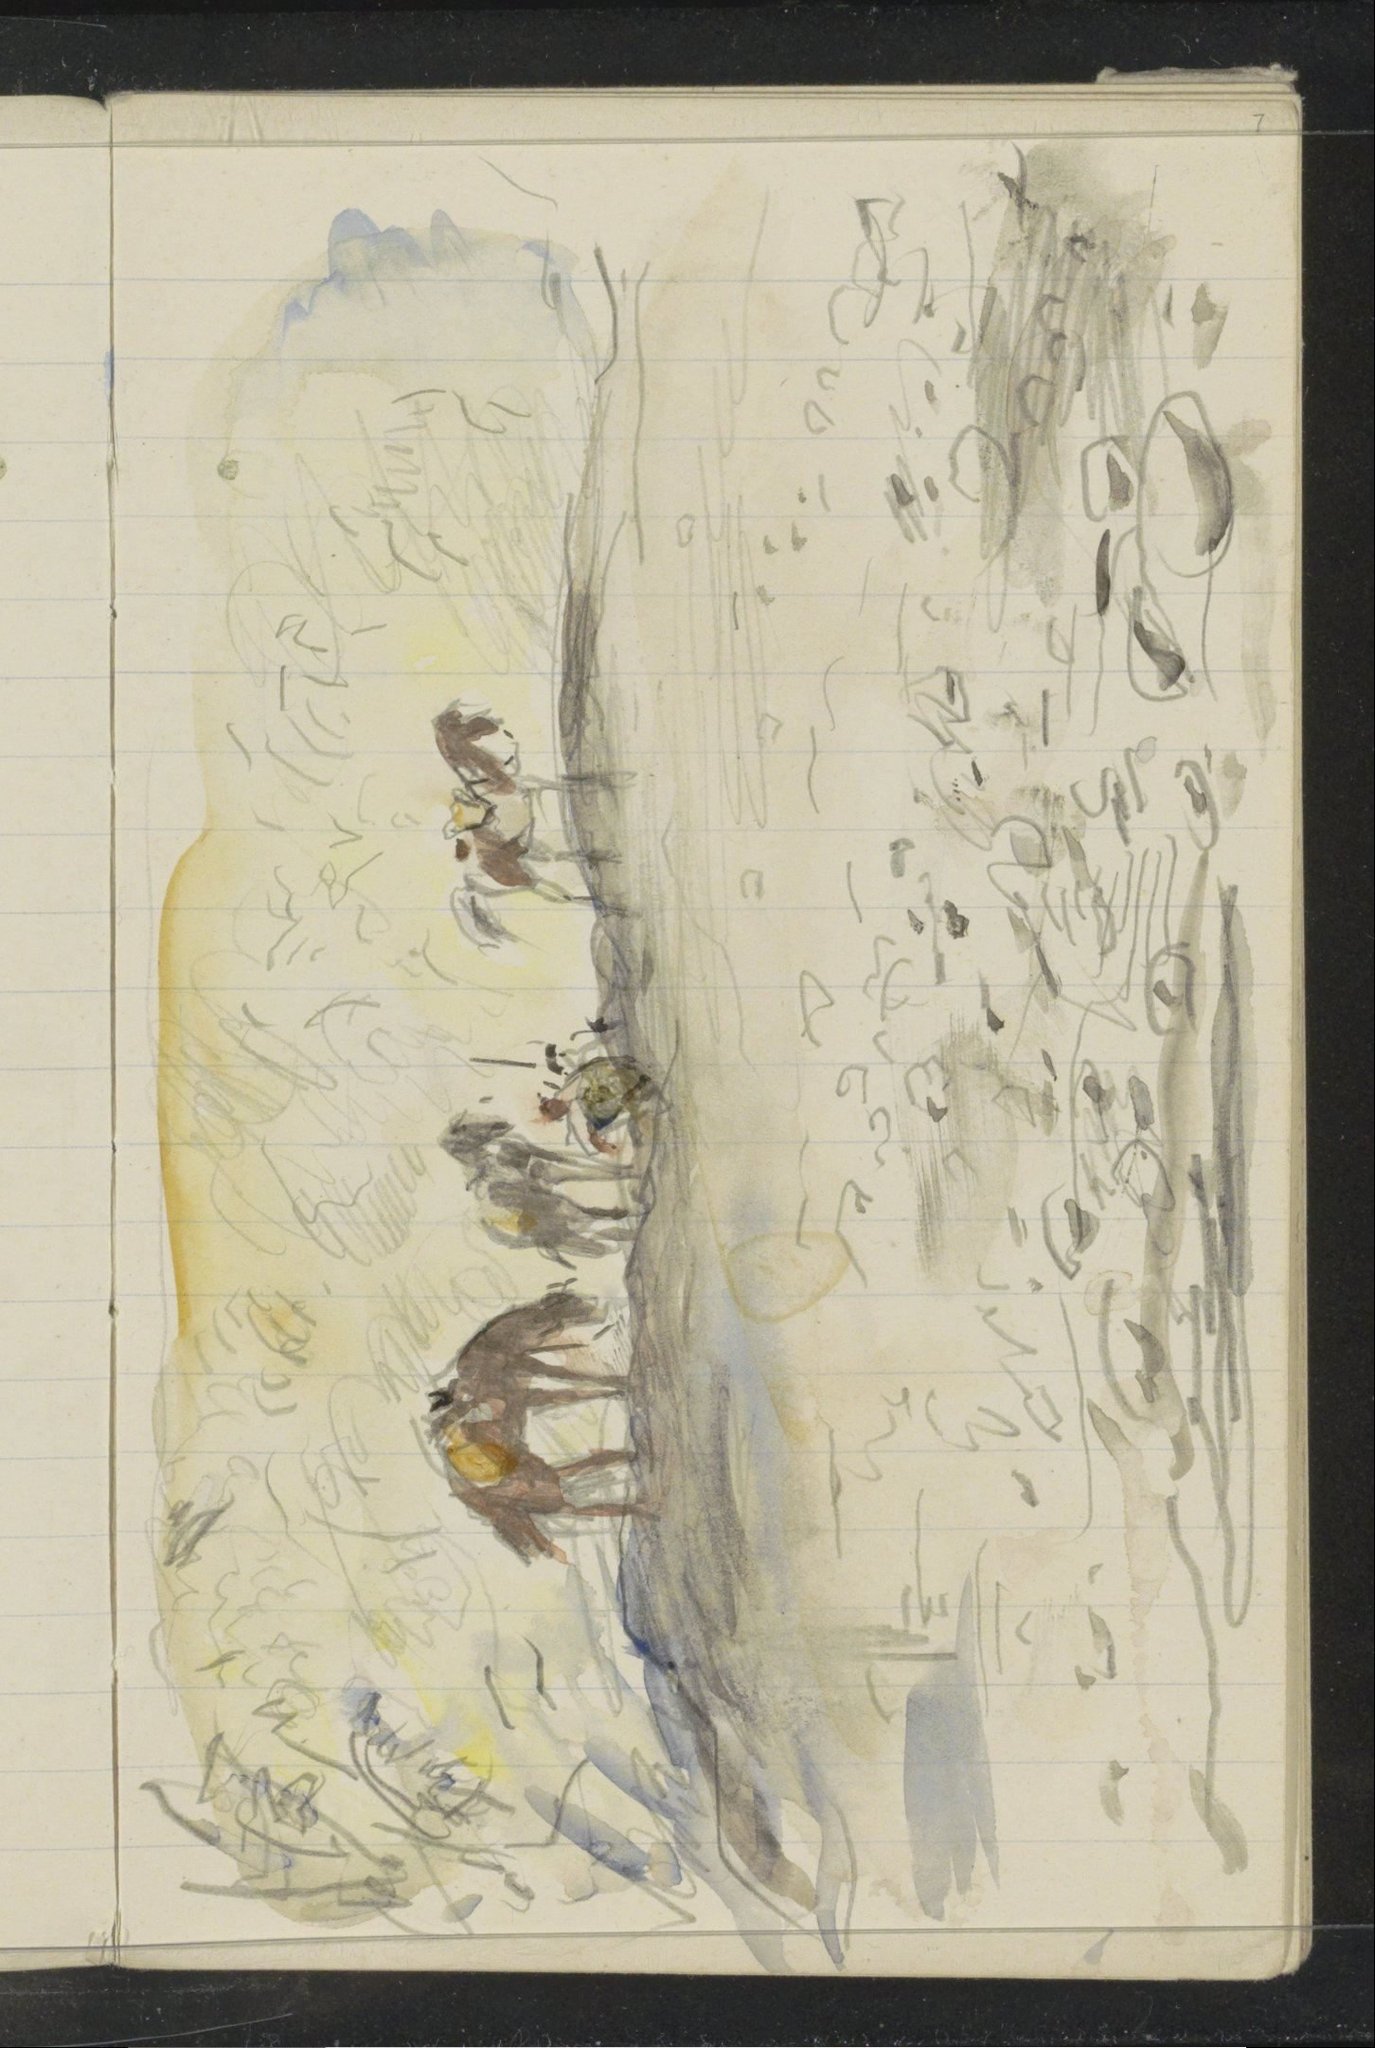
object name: sketchbook leaf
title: Paarden op een vlakte met stenen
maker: marius bauer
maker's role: draughtsman, print maker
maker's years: 1867-1932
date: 1931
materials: pencil, watercolor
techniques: brush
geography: java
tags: trees, horse, boulder, stone, plain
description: Pagina 7 uit een schetsboek met 74 bladen.